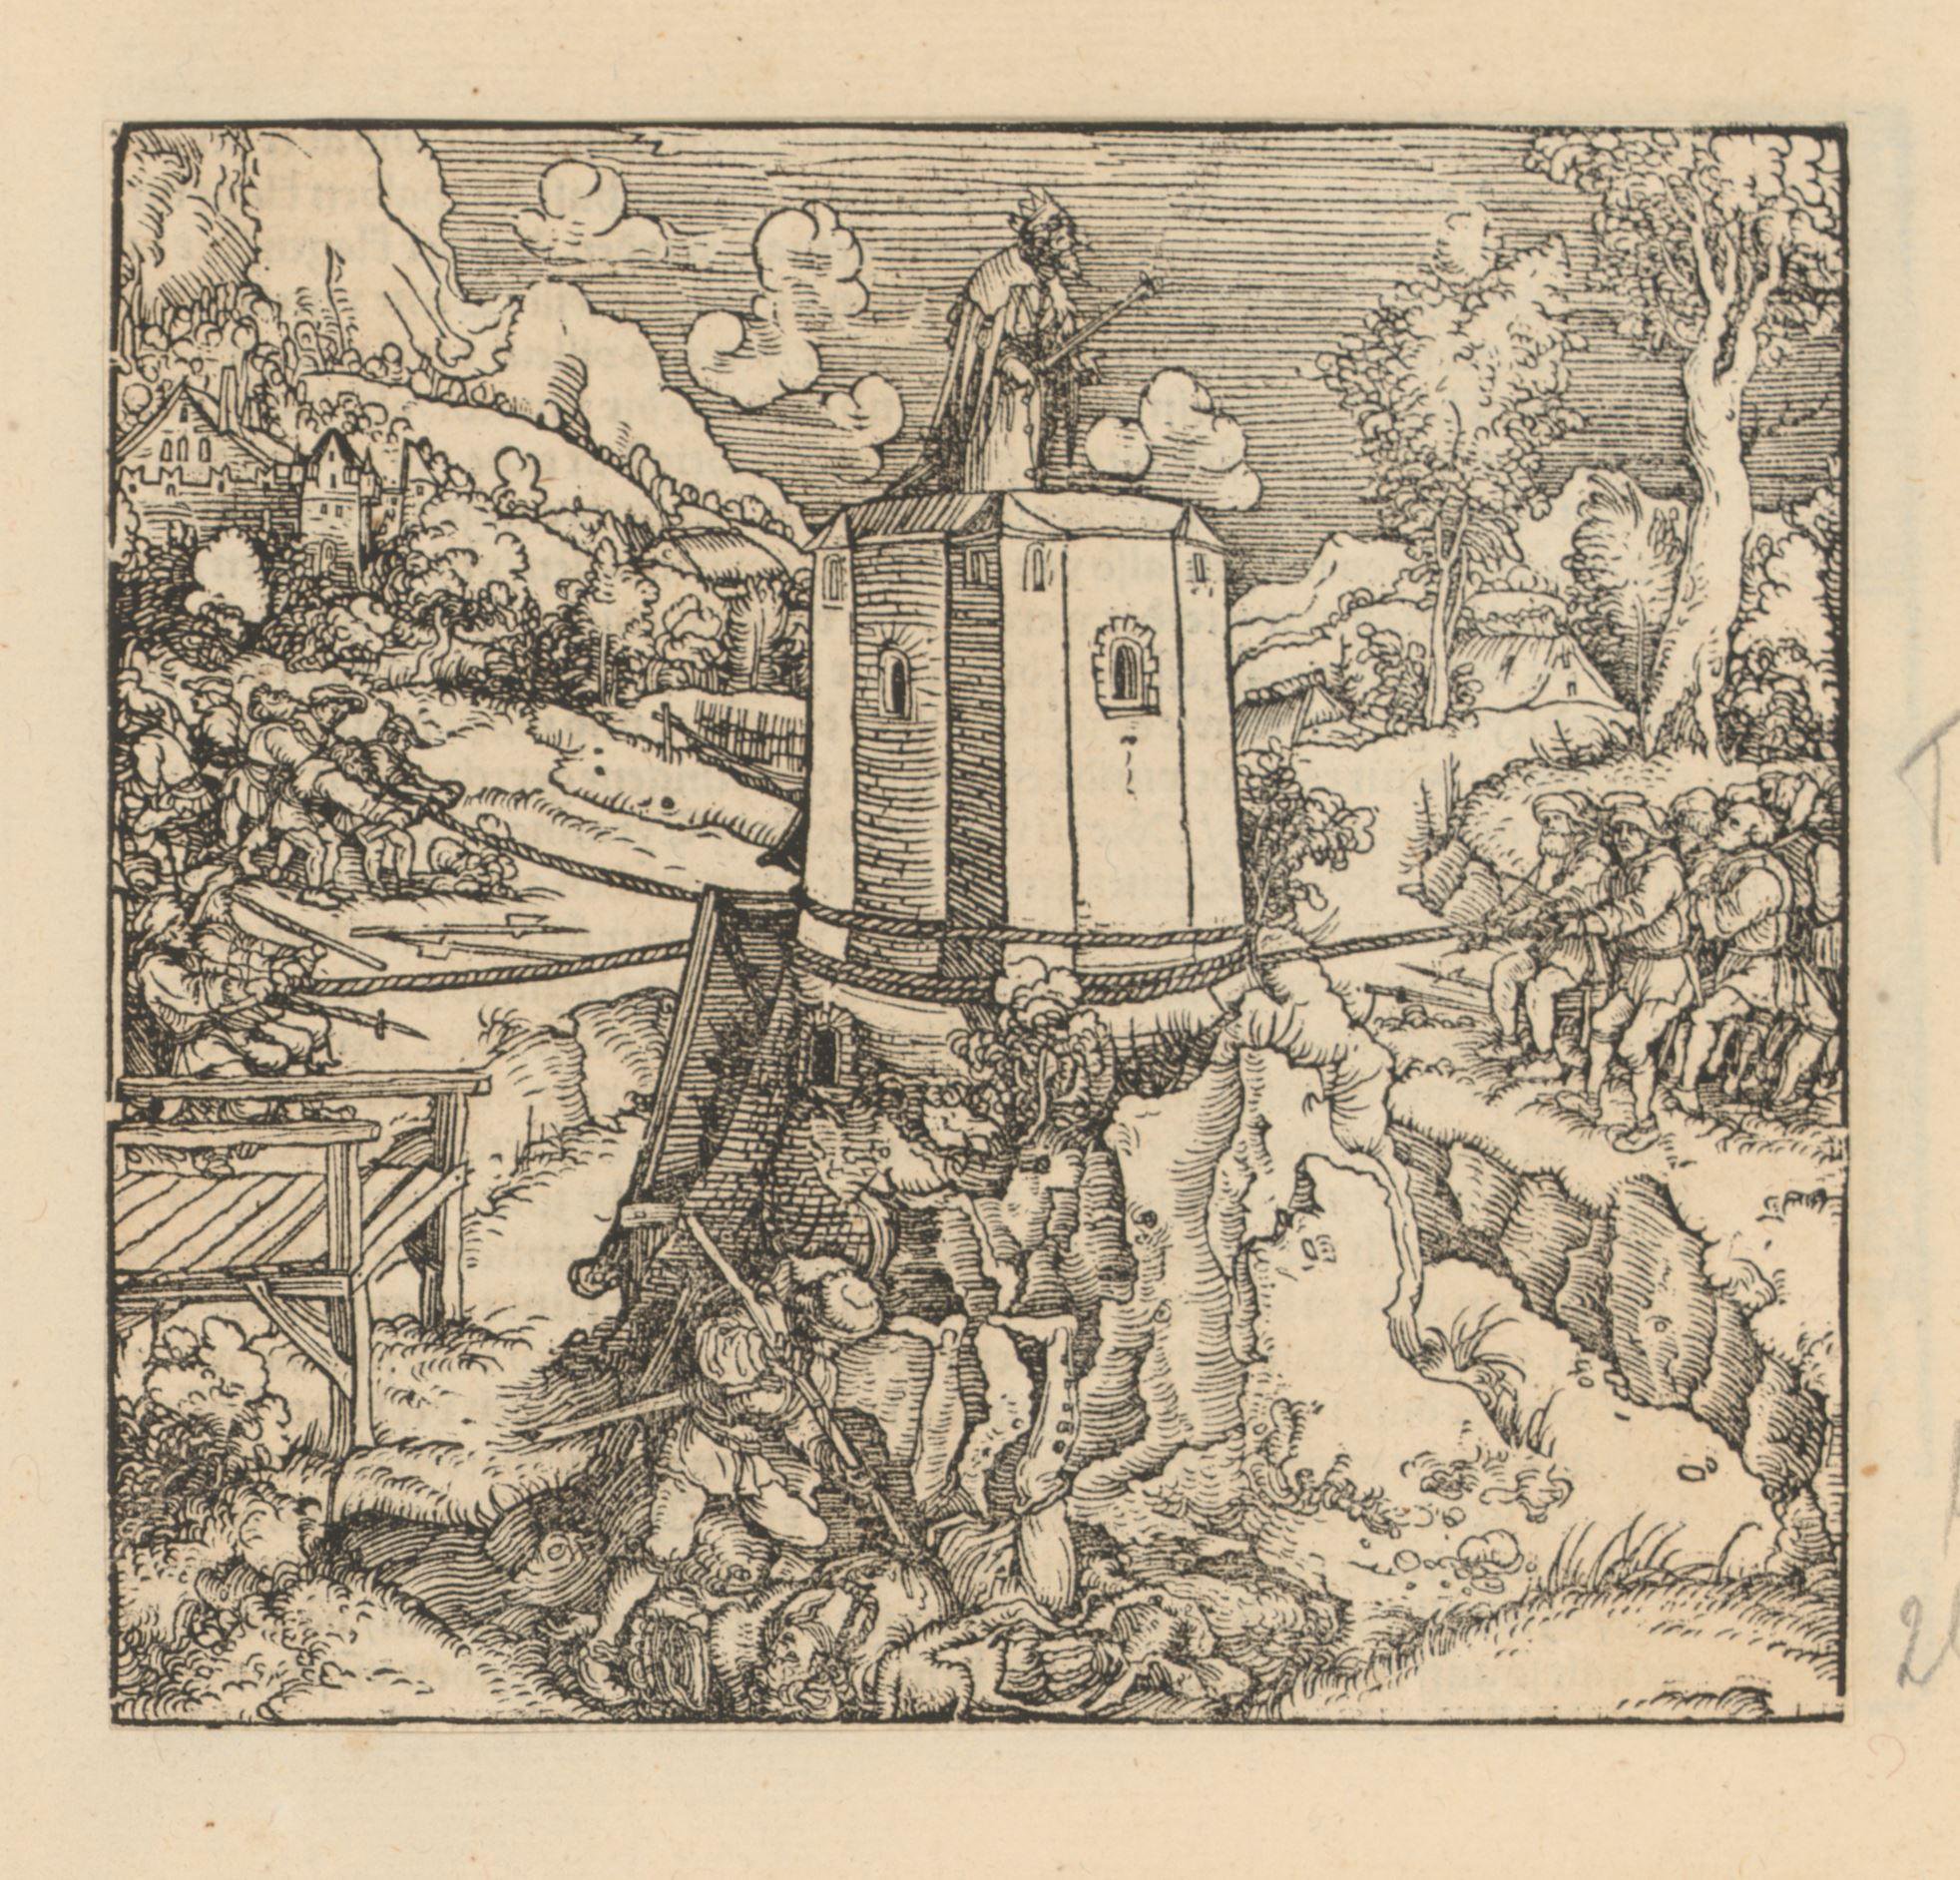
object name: album leaf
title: Heerser op een toren waar van twee kanten aan getrokken wordt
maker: Anonymous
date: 1514-1532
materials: paper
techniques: letterpress printing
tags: ruler, sovereign, revolutionary action (violent)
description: Deze prent is gebruikt in: Petrarca, Francesco. Von der Artzney bayder Glück, des guten und widerwertigen: unnd weß sich ain yeder inn Gelück und Unglück halten sol (...). Augsburg: Heinrich Steiner, 1532. Deze uitgave is ook bekend onder de titel 'Trostspiegel in Glück und Unglück'.